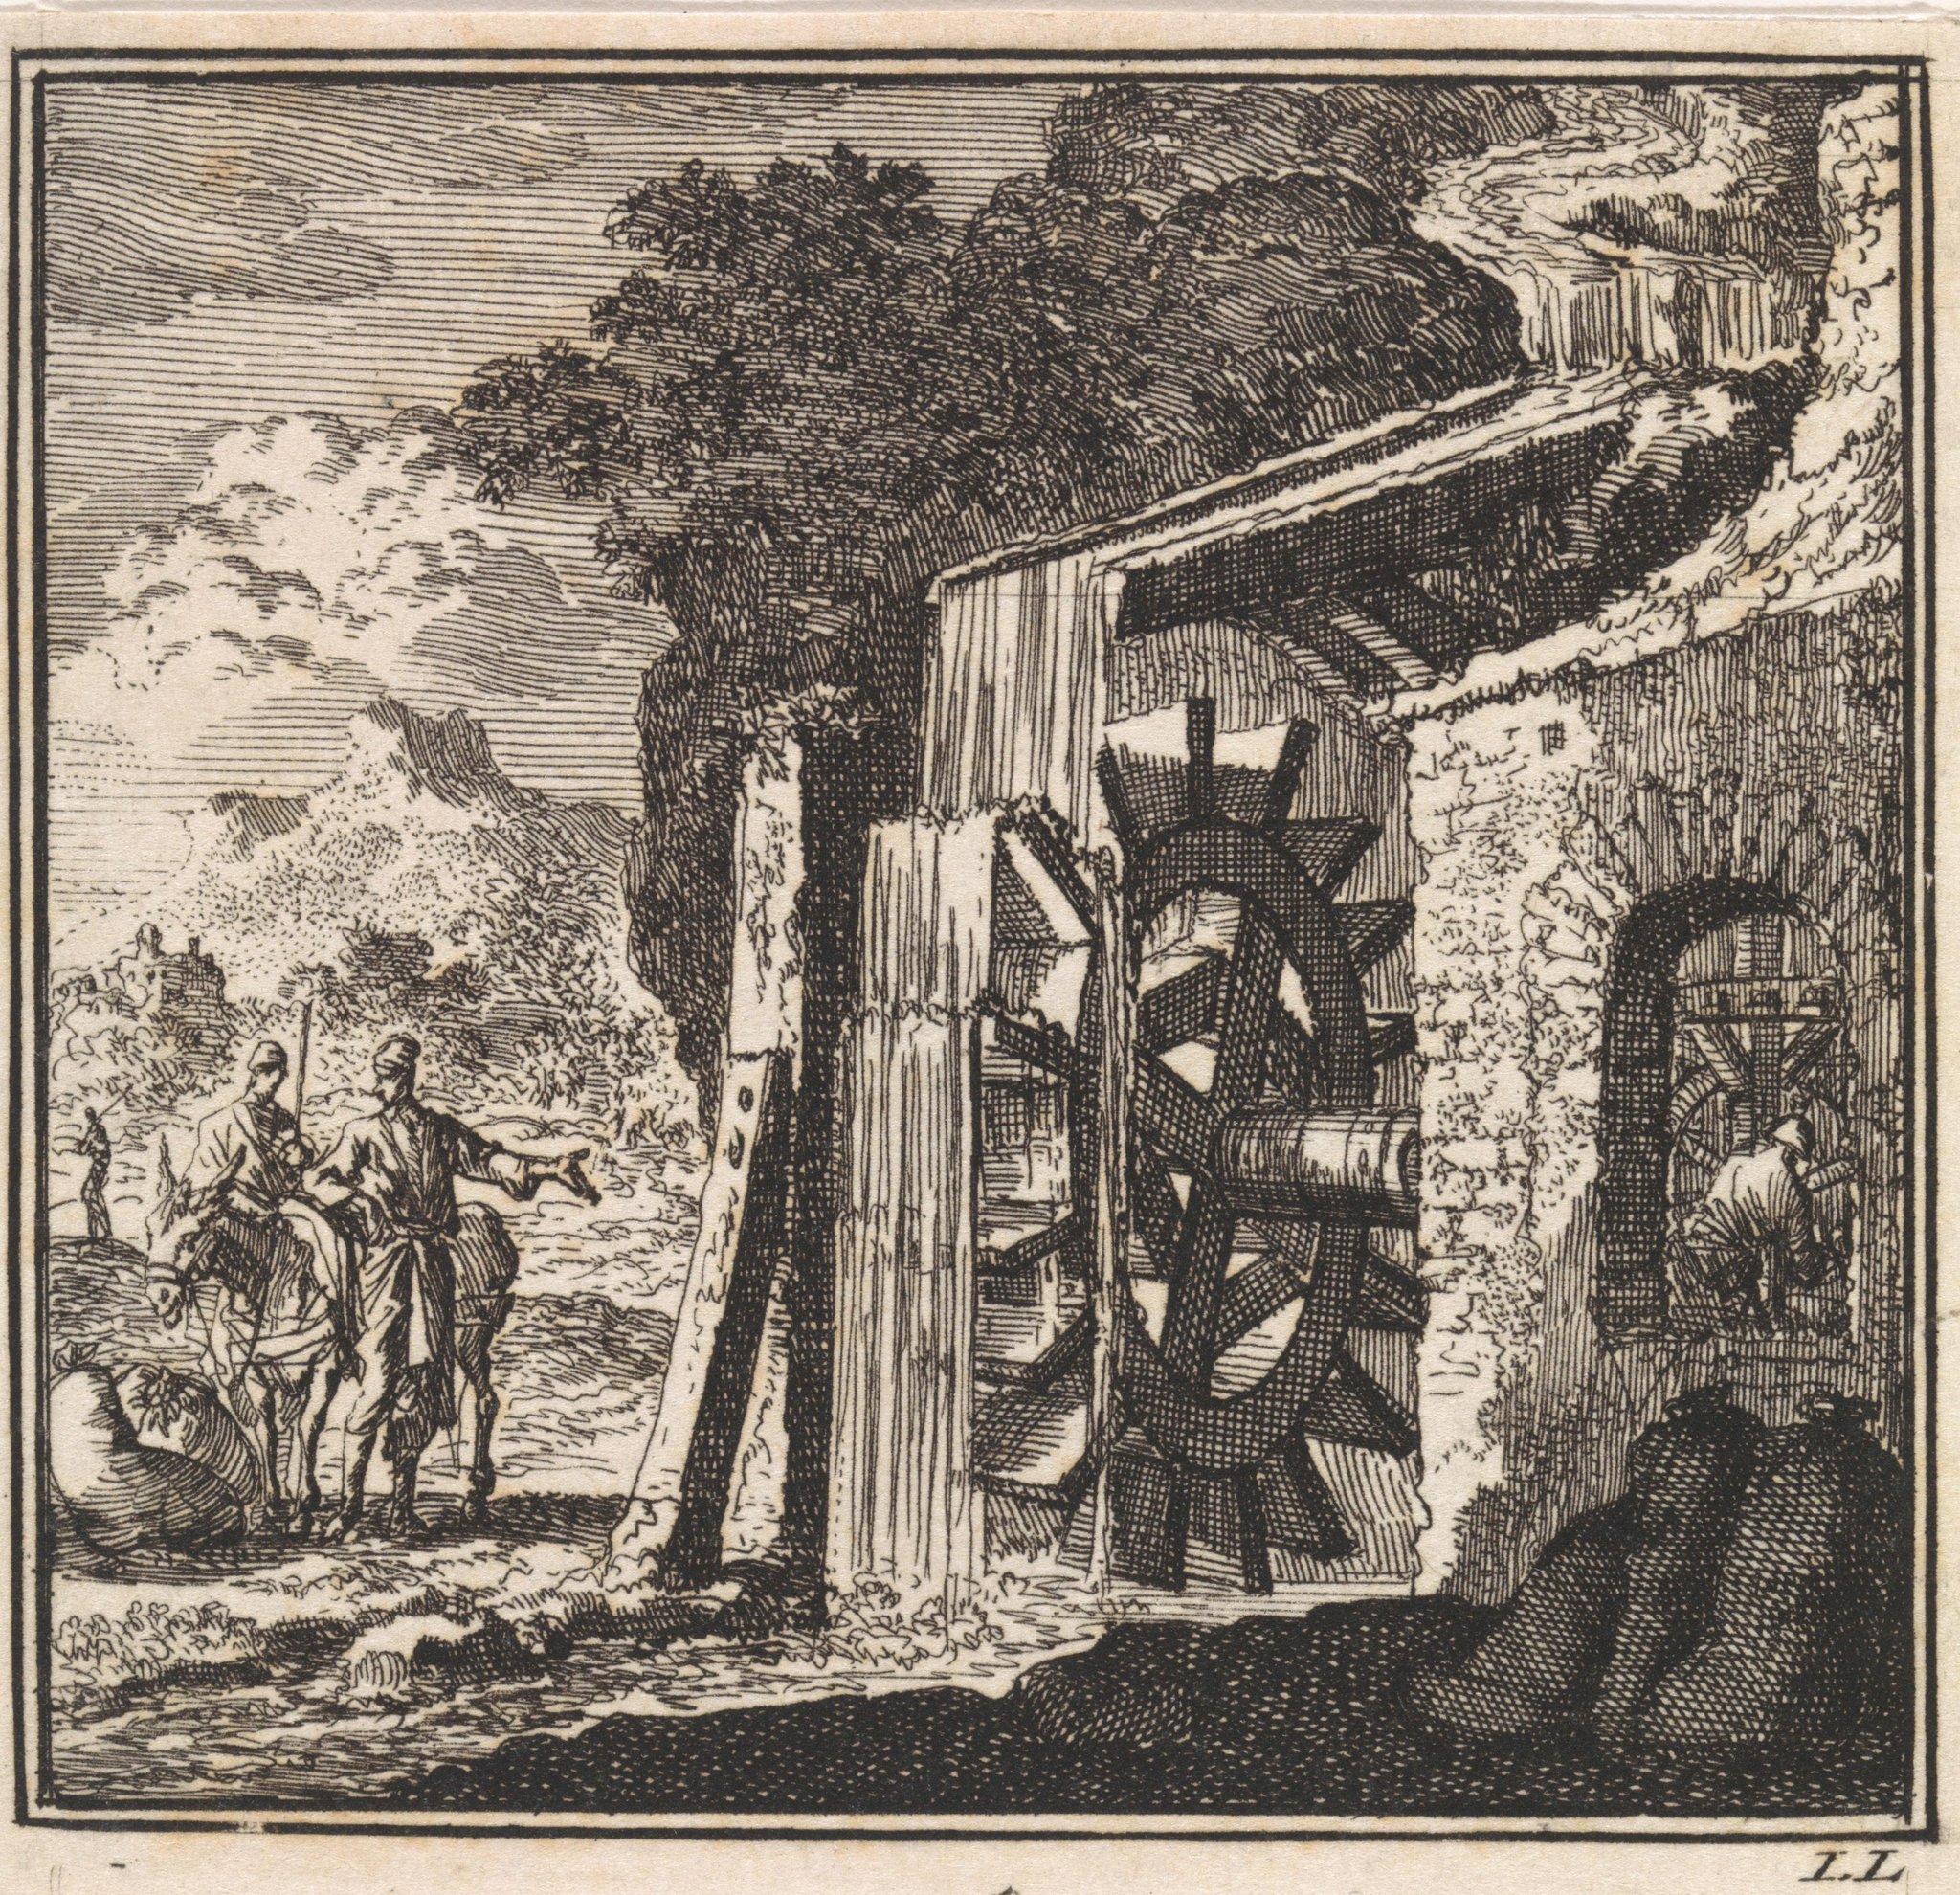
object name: book illustration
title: De Molen door ware beweegd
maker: jan luyken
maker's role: draughtsman, print maker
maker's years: 1649-1712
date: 1711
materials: paper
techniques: etching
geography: amsterdam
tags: watermill, 'en route', traveller under way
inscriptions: collector's mark: Lugt 2228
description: Illustratie voor: Luyken, Jan. De Bykorf des Gemoeds. Amsterdam: Pieter Arentsz. II (wed.) en Cornelis van der Sys, 1711, p. 18.